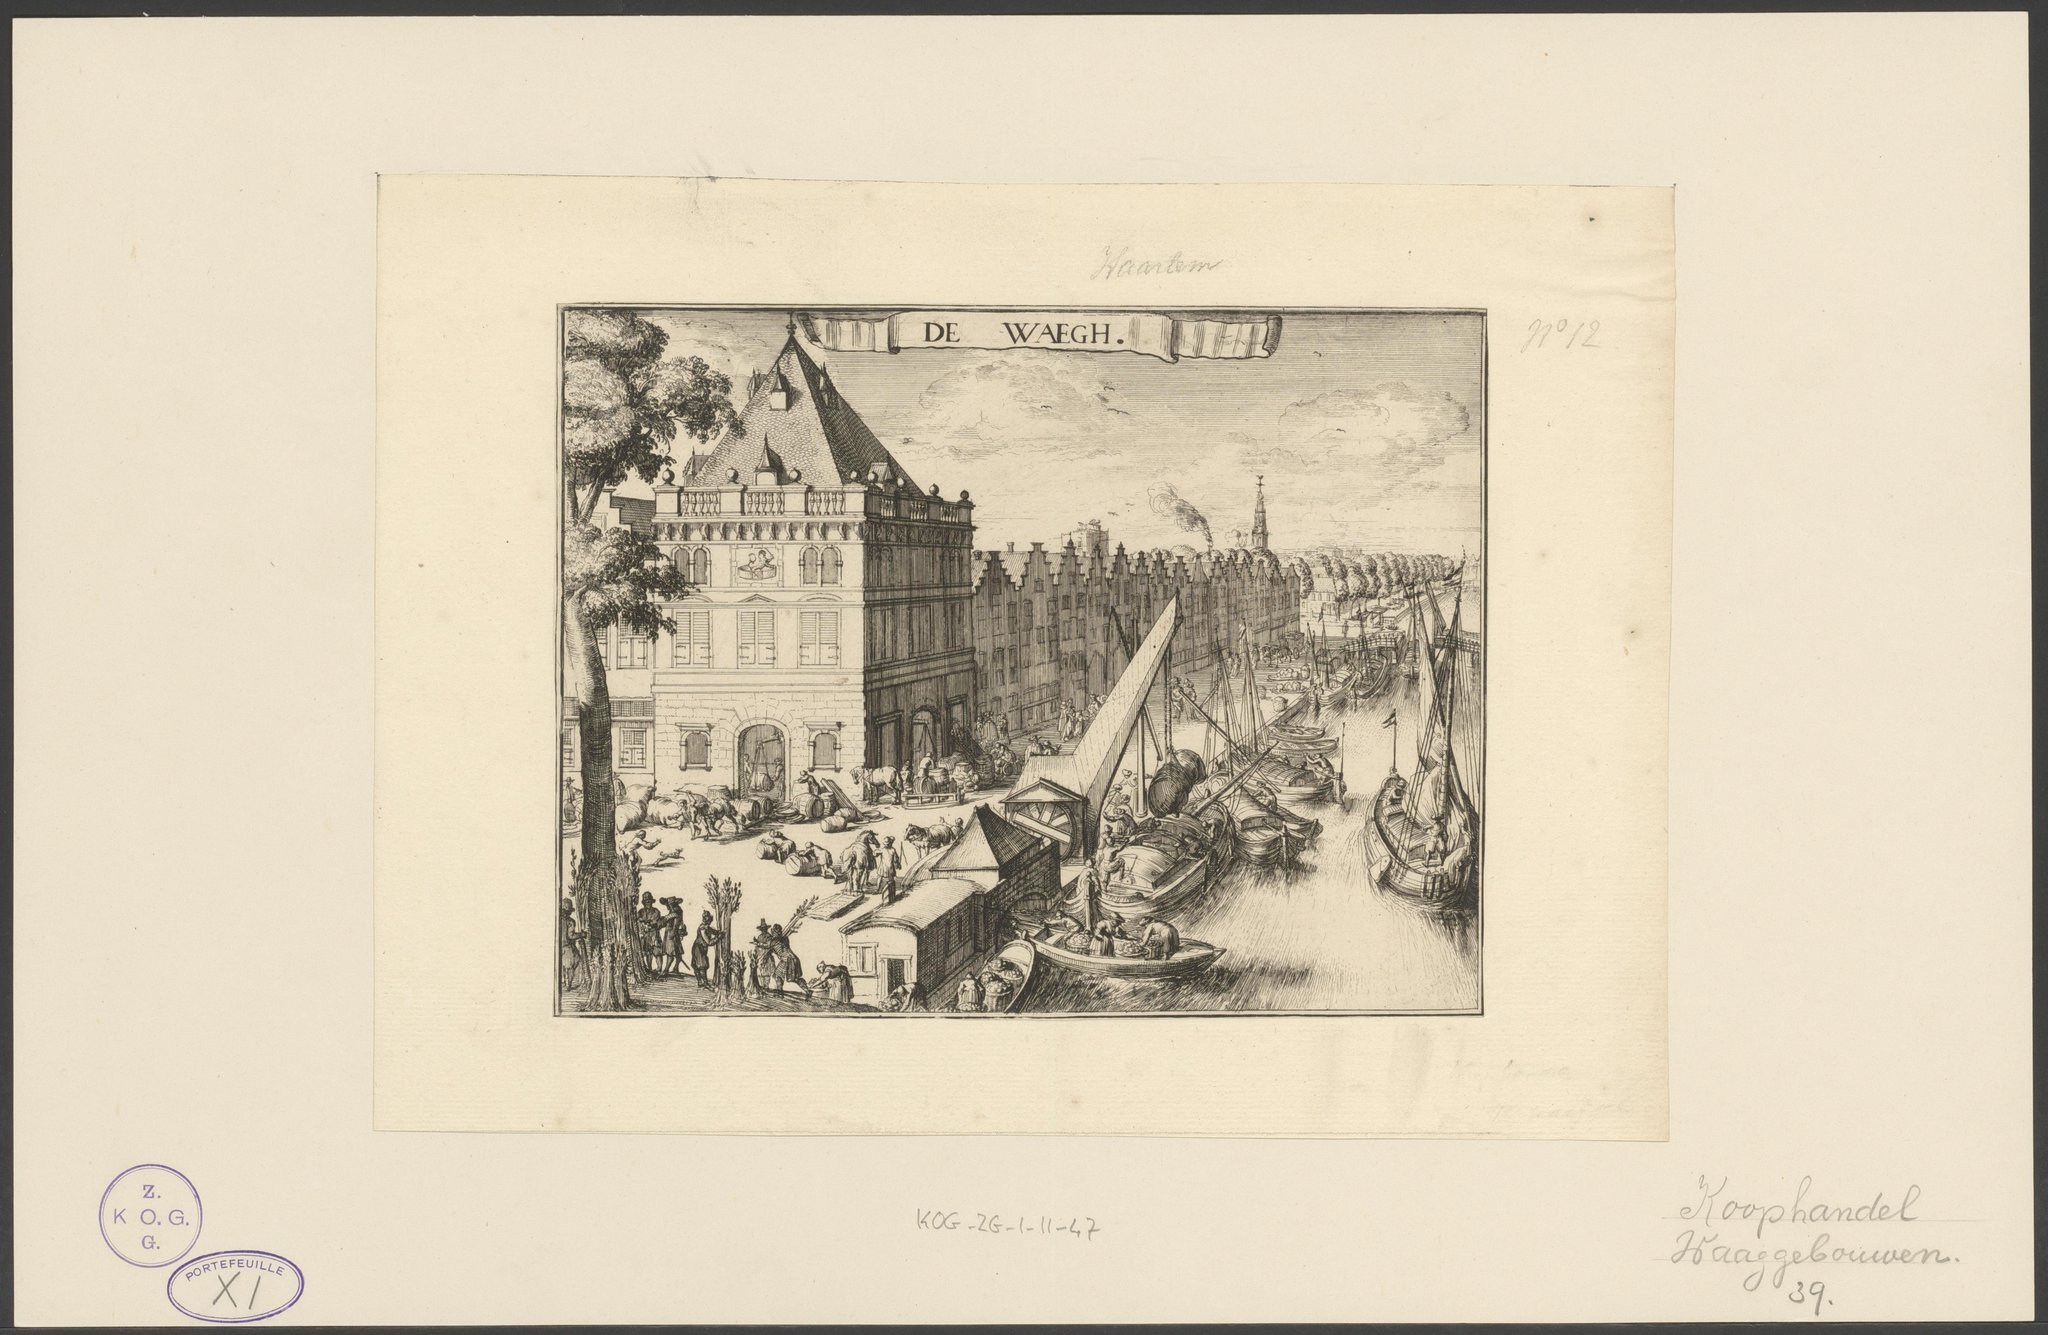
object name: print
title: Gezicht op de Waag te Haarlem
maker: romeyn de hooghe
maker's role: draughtsman, goldsmith, painter, print maker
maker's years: 1645-1708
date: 1688-1689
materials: paper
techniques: engraving, etching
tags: weigh-house, haarlem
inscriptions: stamp, collector's mark: Lugt 1641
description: Gezicht op de Waag te Haarlem aan het Spaarne, , met vele handelaars die hun koopwaren per boot of ton erheen brengen. Dit blad maakt deel uit van een omvangrijke prent met een grote plattegrond van Haarlem, omgeven door zeven wapenschilden, een profiel van de stad, gezichten op markante Haarlemse gebouwen en voorstellingen van belangrijke momenten uit de Haarlemse geschiedenis. Onderwerpsrubrieken binnen de Atlas Zeden en Gewoonten: Handel, Nijverheid en Verkeer, Koophandel, Waaggebouwen.